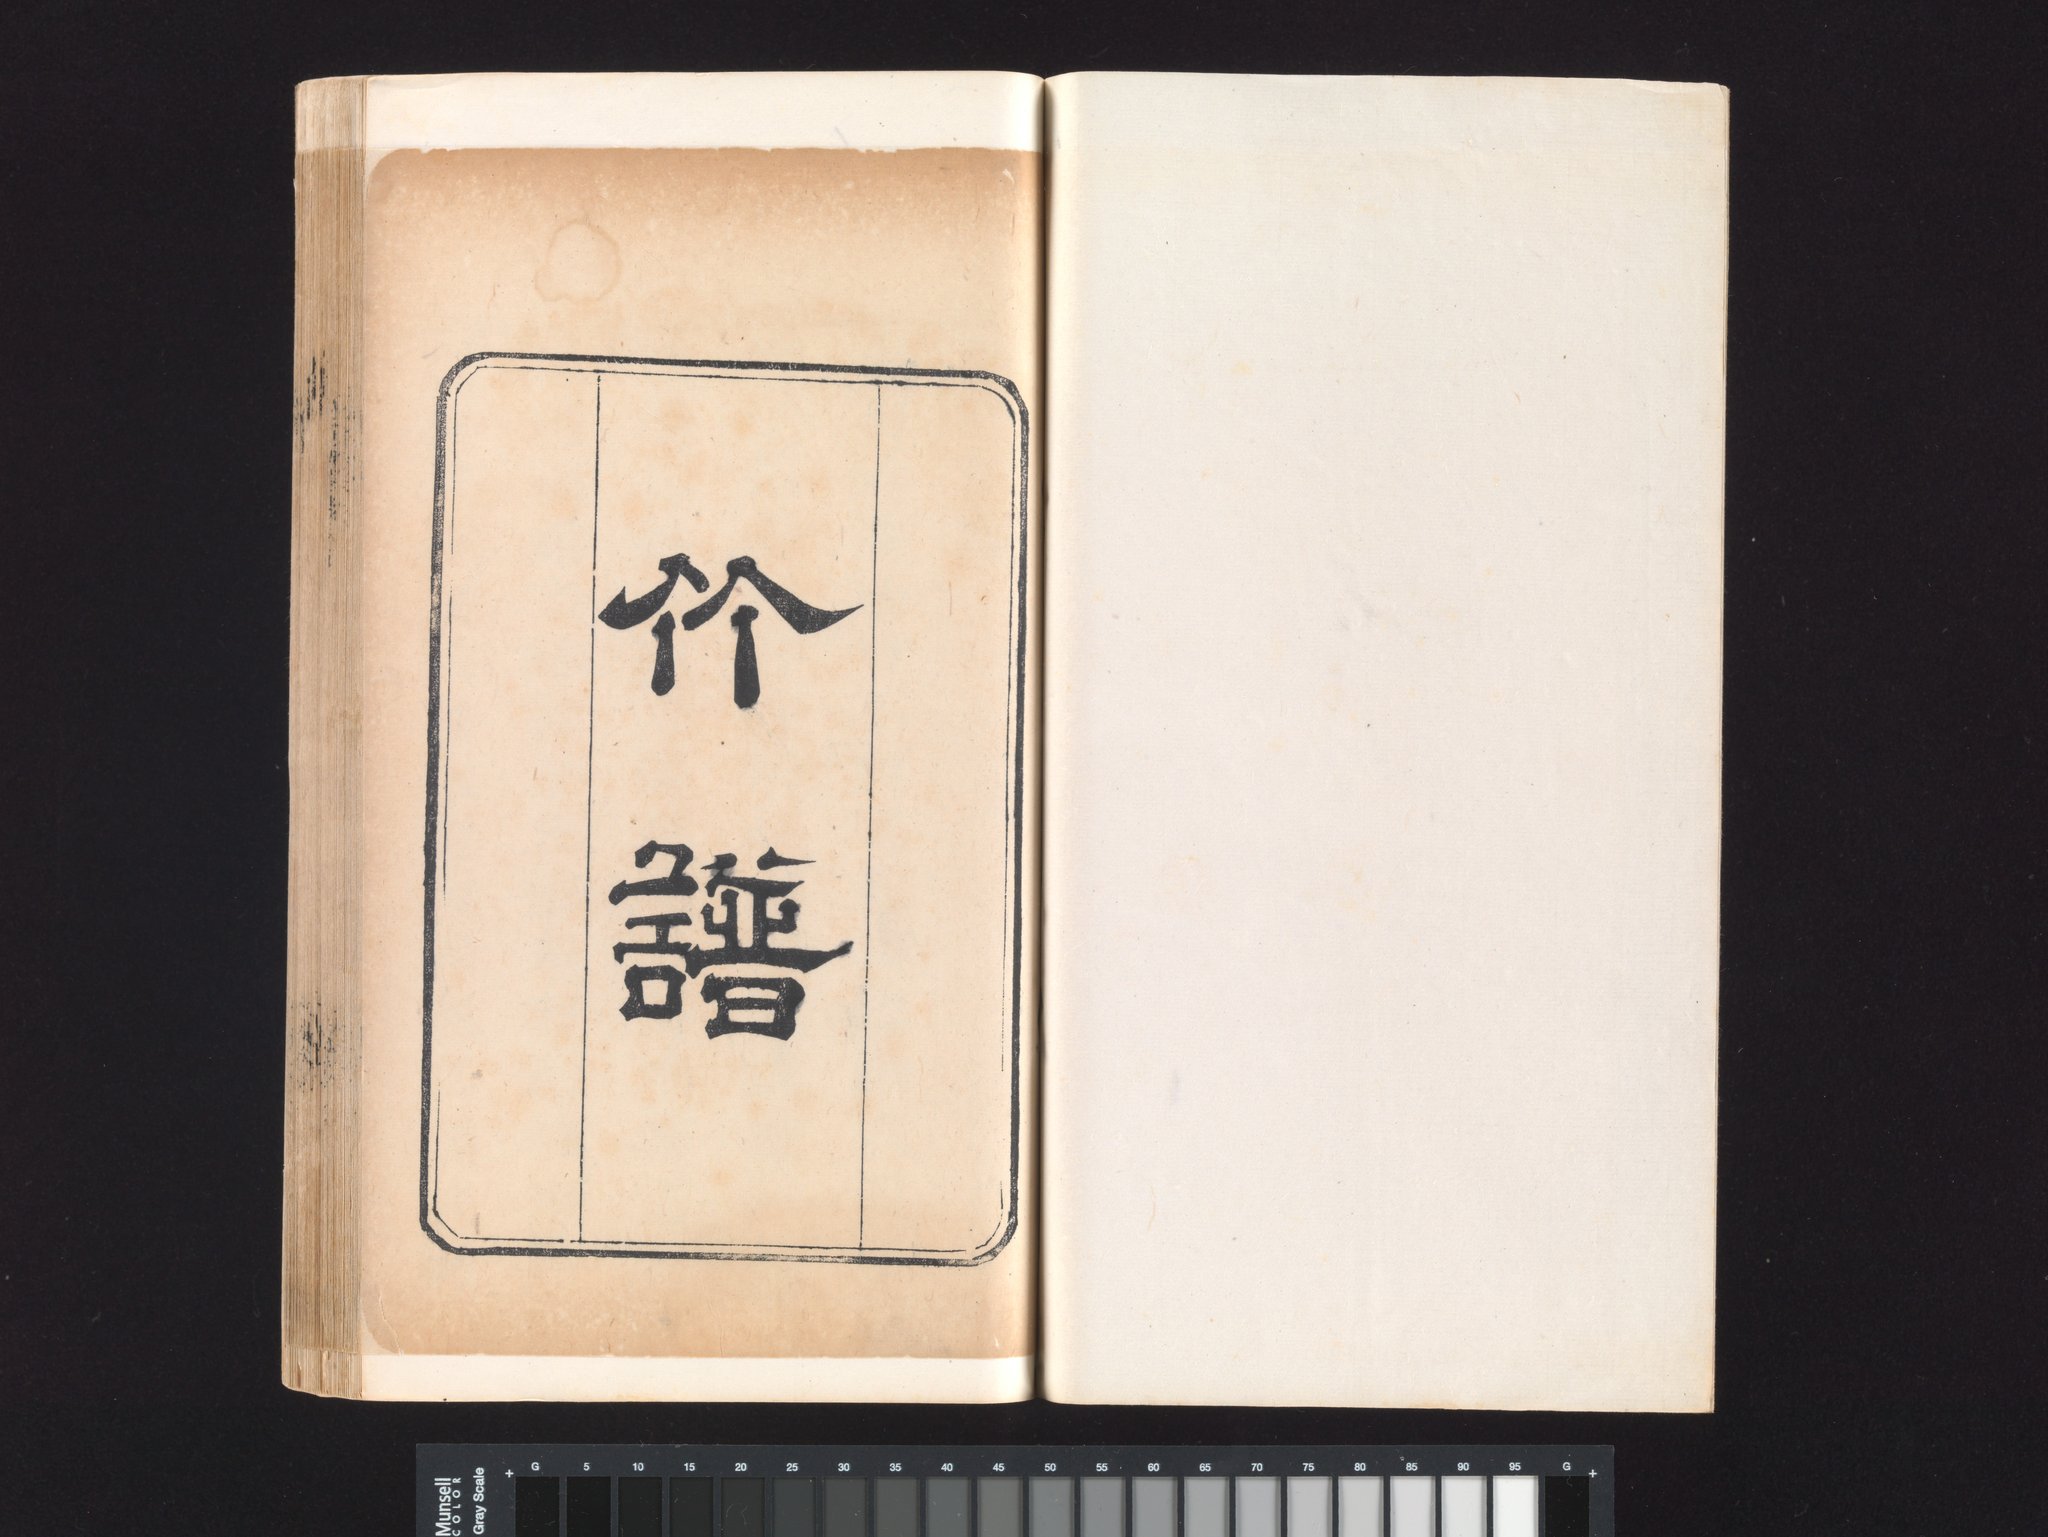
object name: illustrated book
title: “Bamboo” section, from the Mustard Seed Garden Manual of Painting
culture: chinese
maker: wang gai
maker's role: artist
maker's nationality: chinese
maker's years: 1645-1710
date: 1817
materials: ink, paper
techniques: woodblock print